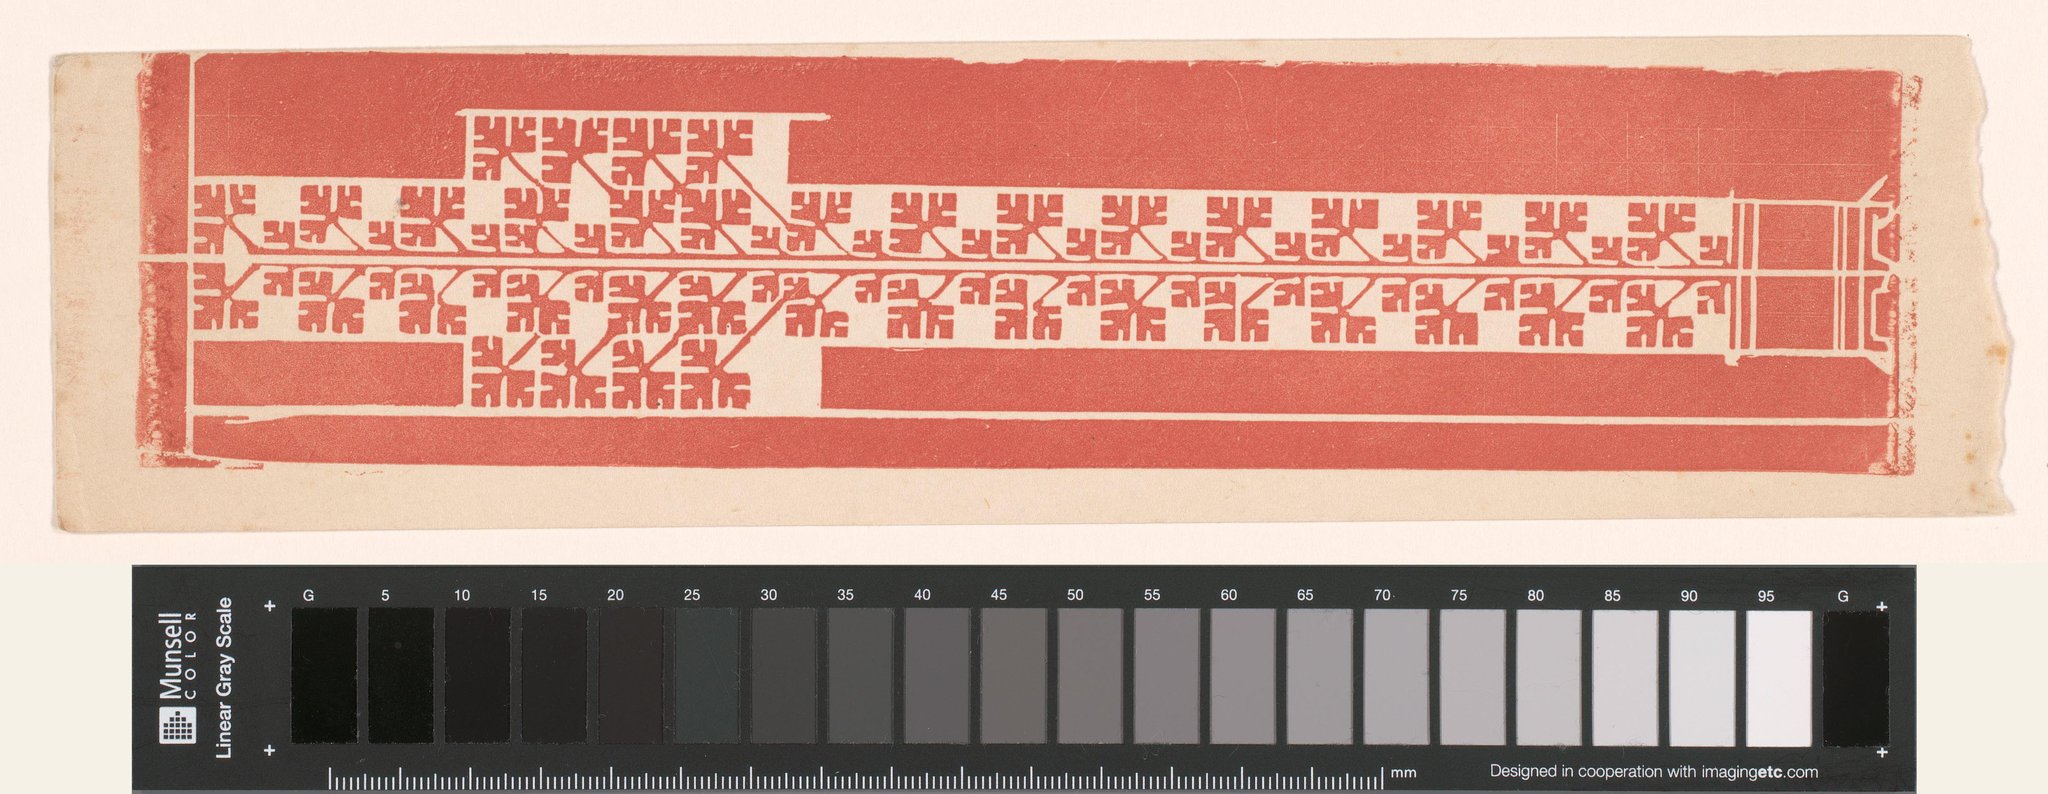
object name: boekillustratie ontwerp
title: Ornament met bladeren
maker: bernard willem wierink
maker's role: draughtsman, print maker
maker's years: 1856-1939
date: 1910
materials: paper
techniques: relief print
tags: fable of reynard the fox, foliage, tendrils, branches ~ ornament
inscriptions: collector's mark: Lugt 2228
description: Ontwerp voor: Streuvels, Stijn (Frank Lateur). Reinaert de Vos naar verschillende uitgaven van het middeleeuwsche epos. Amsterdam: L.J. Veen, 1910. Deze prent is vermoedelijk een plaatsnede, ook al wordt in de literatuur veelal gesproken over een houtsnede. Voor zover Wierink zijn prenten in hoogdruk zelf nader heeft omschreven, heeft hij altijd de term 'plaatsnede' gebruikt.